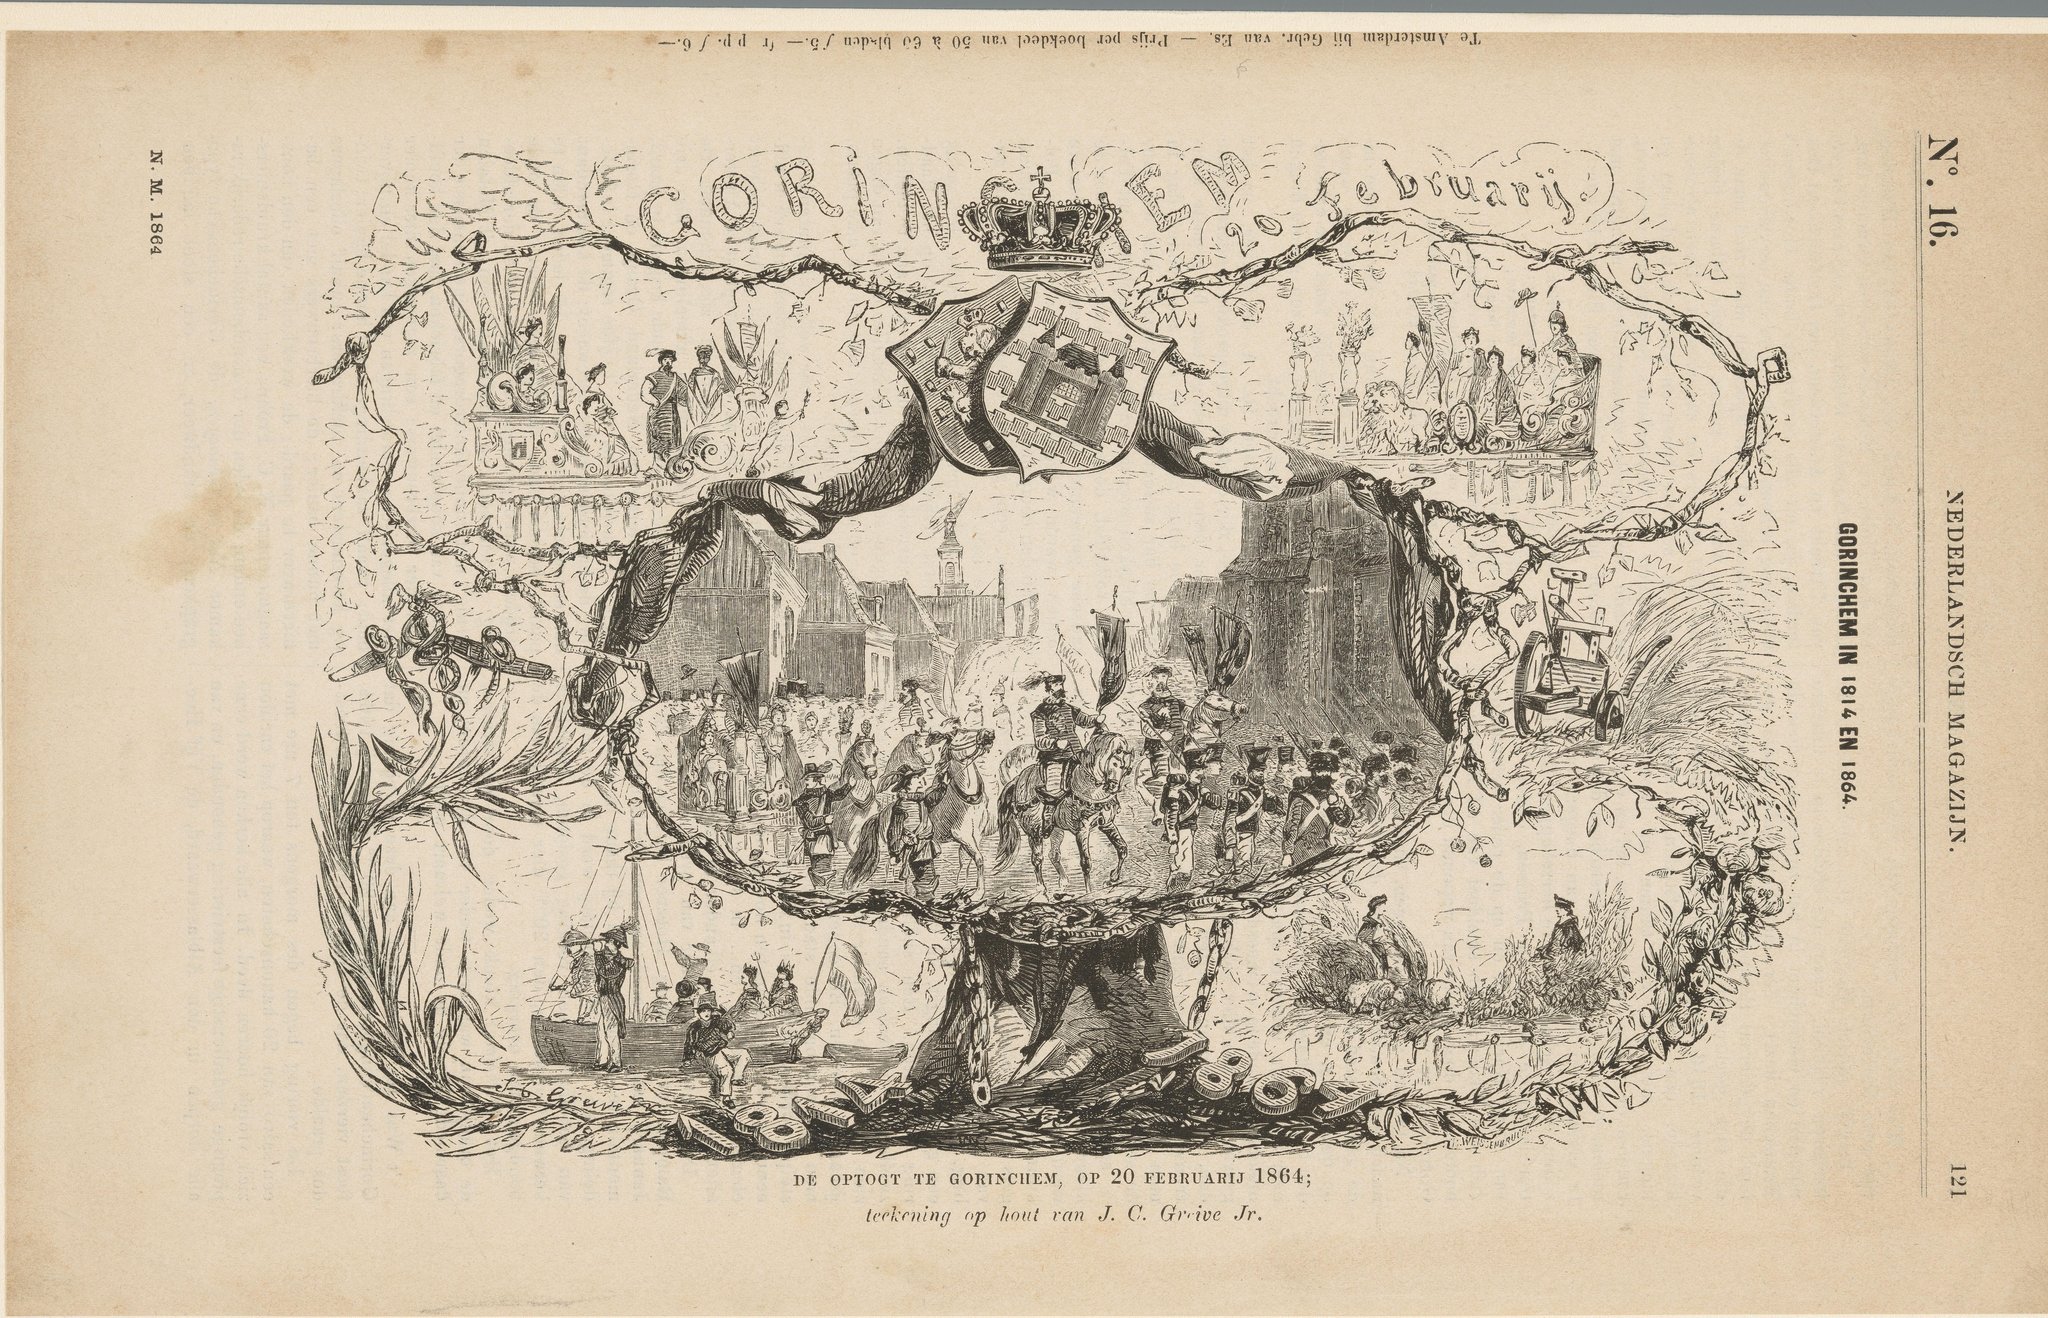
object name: book illustration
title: Optocht te Gorinchem op 20 februari 1864 ter herinnering aan de bevrijding van Gorinchem op 20 februari 1814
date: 1864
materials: paper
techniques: letterpress printing, engraving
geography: amsterdam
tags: gorinchem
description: Prent uit: Nederlandsch magazijn. Amsterdam: Gebr. van Es, 1864.